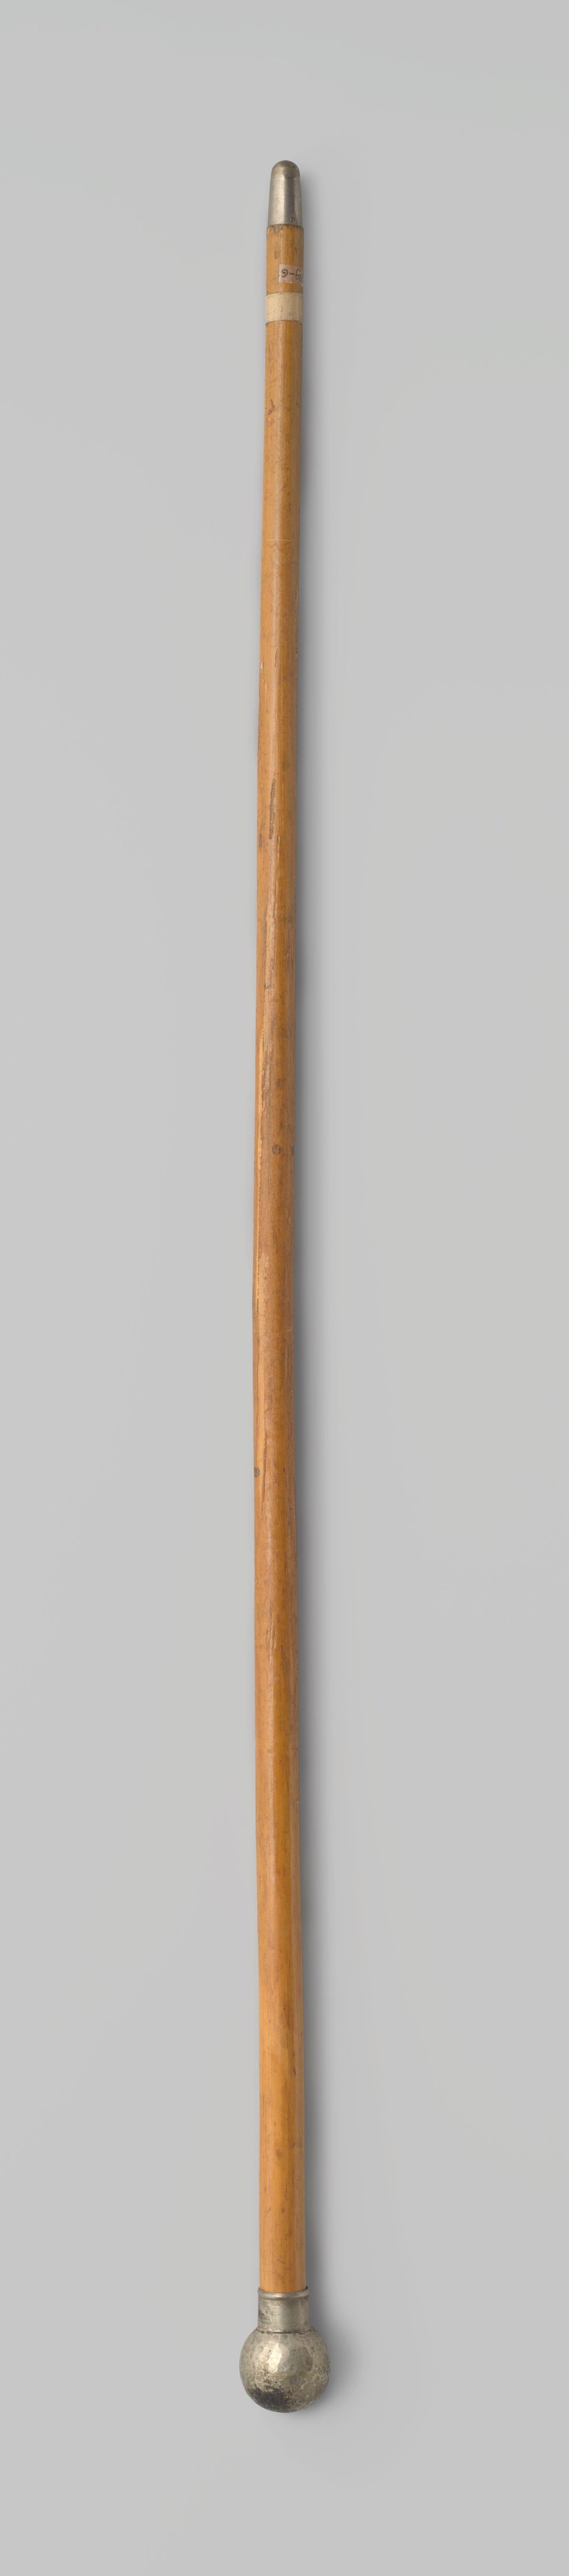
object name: onderstok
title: Onderstok van parasol of parapluie van rotting met alpaca bol op ring en voorzien van stompe, metalen punt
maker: gustav schnitzler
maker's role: paraplufabrikant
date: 1920-1940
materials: alloy, metal, rattan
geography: nijmegen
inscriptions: inscription: ‘?IPACCA’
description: Onderstok van parasol of parapluie van rotting met alpaca bol op ring en voorzien van stompe, metalen punt.